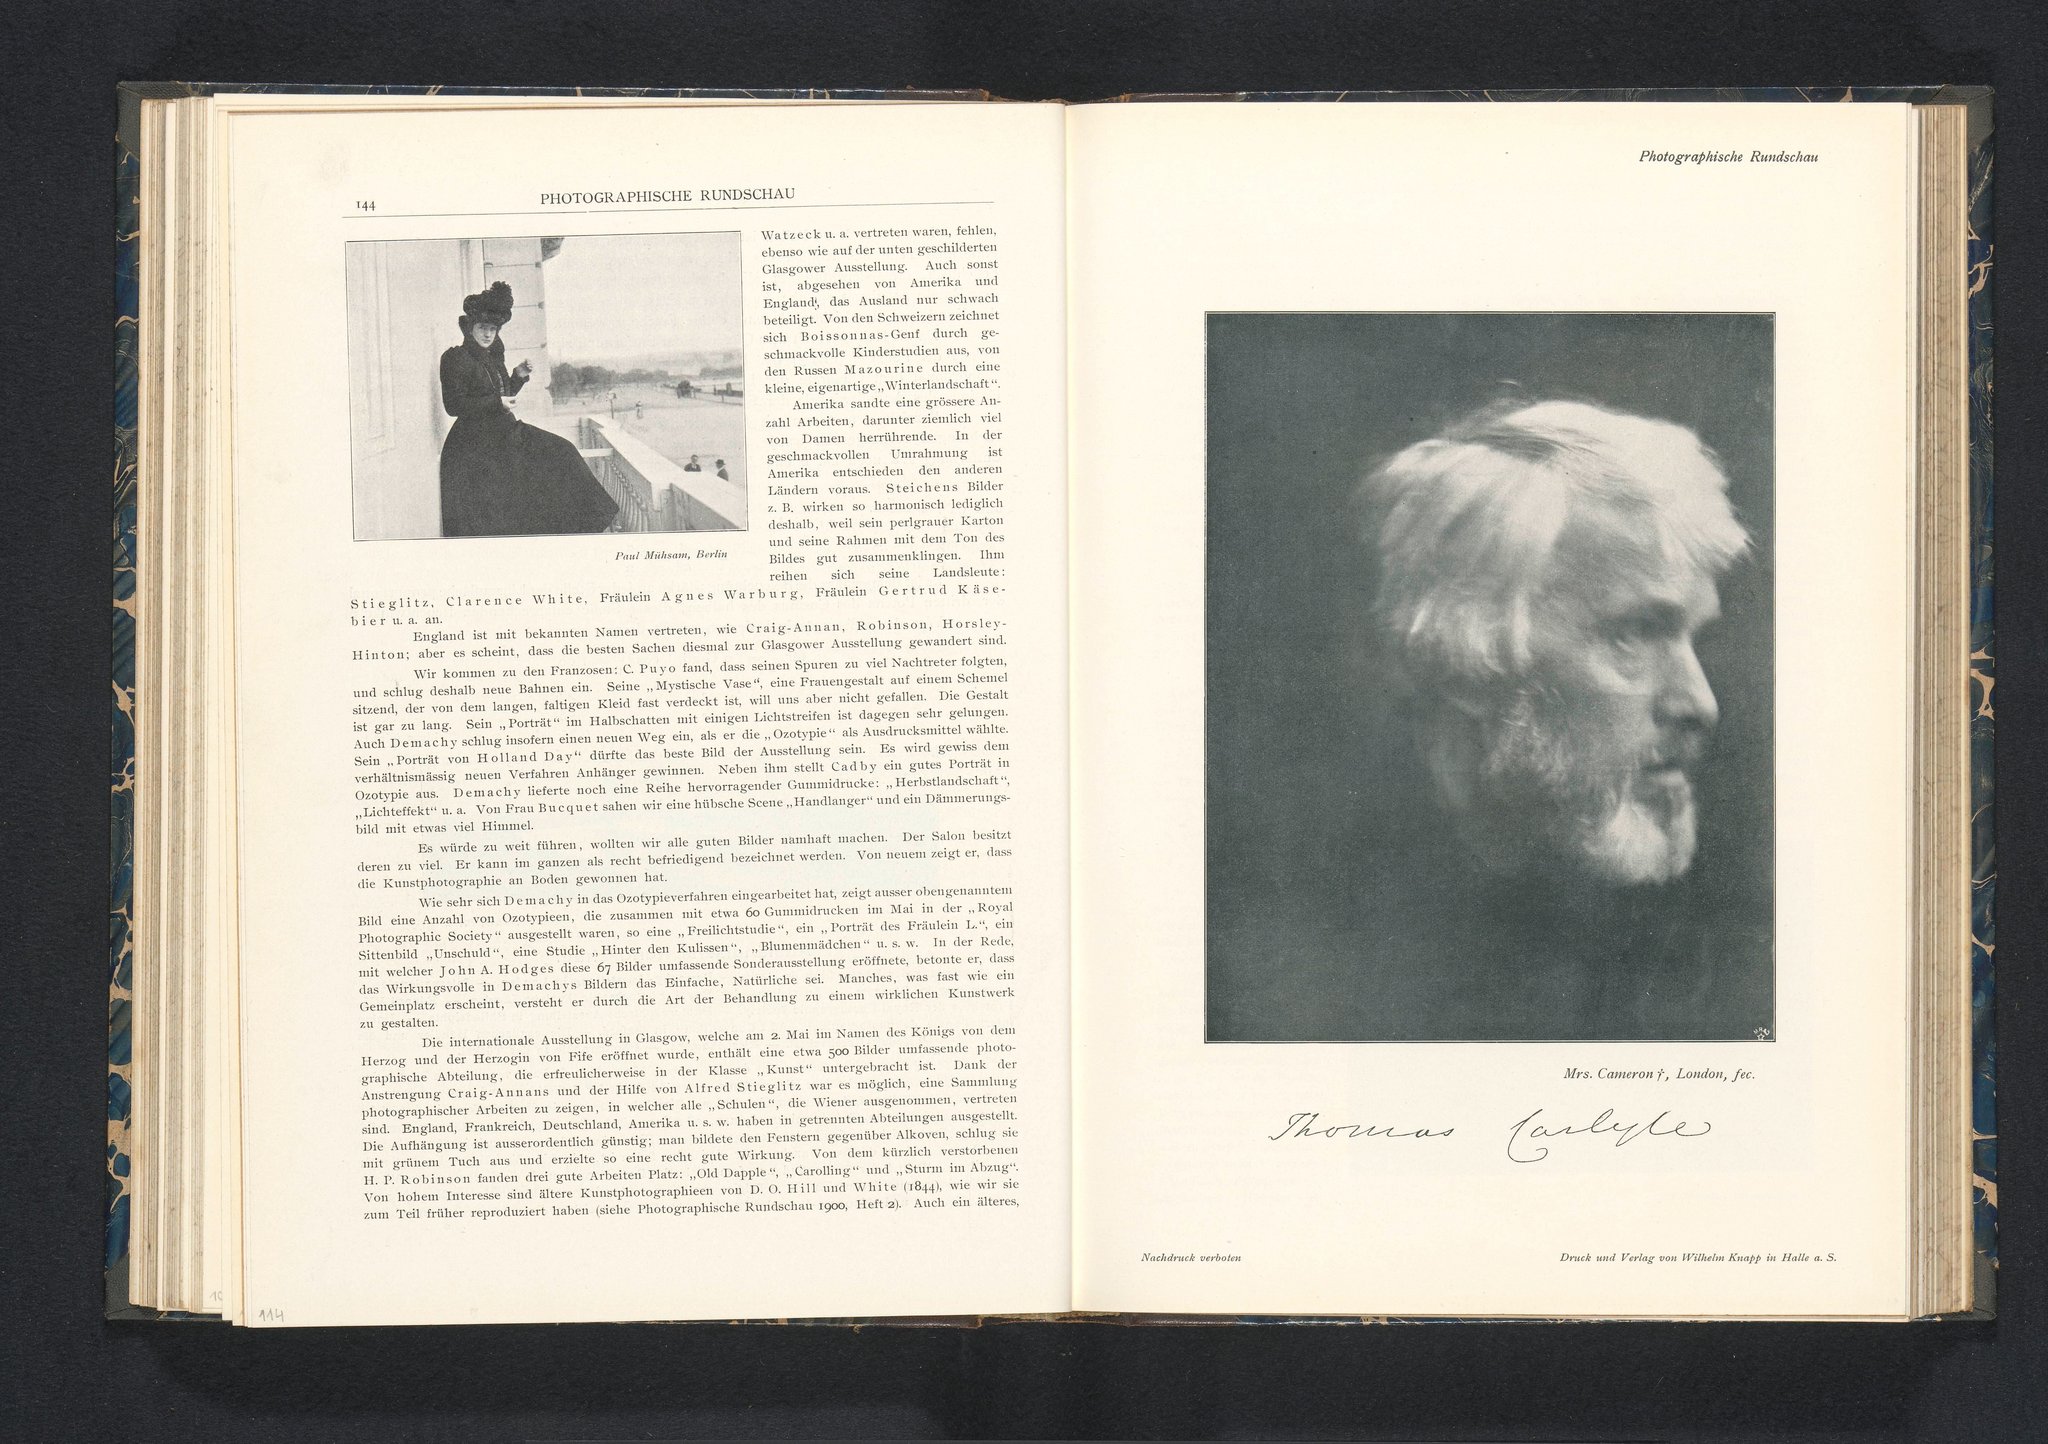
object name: page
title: Portret van een onbekende vrouw in een zwarte jurk en een zwarte hoed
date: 1896-1901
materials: paper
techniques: autotype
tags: historical persons not known by name - bb - woman, head-gear: hat